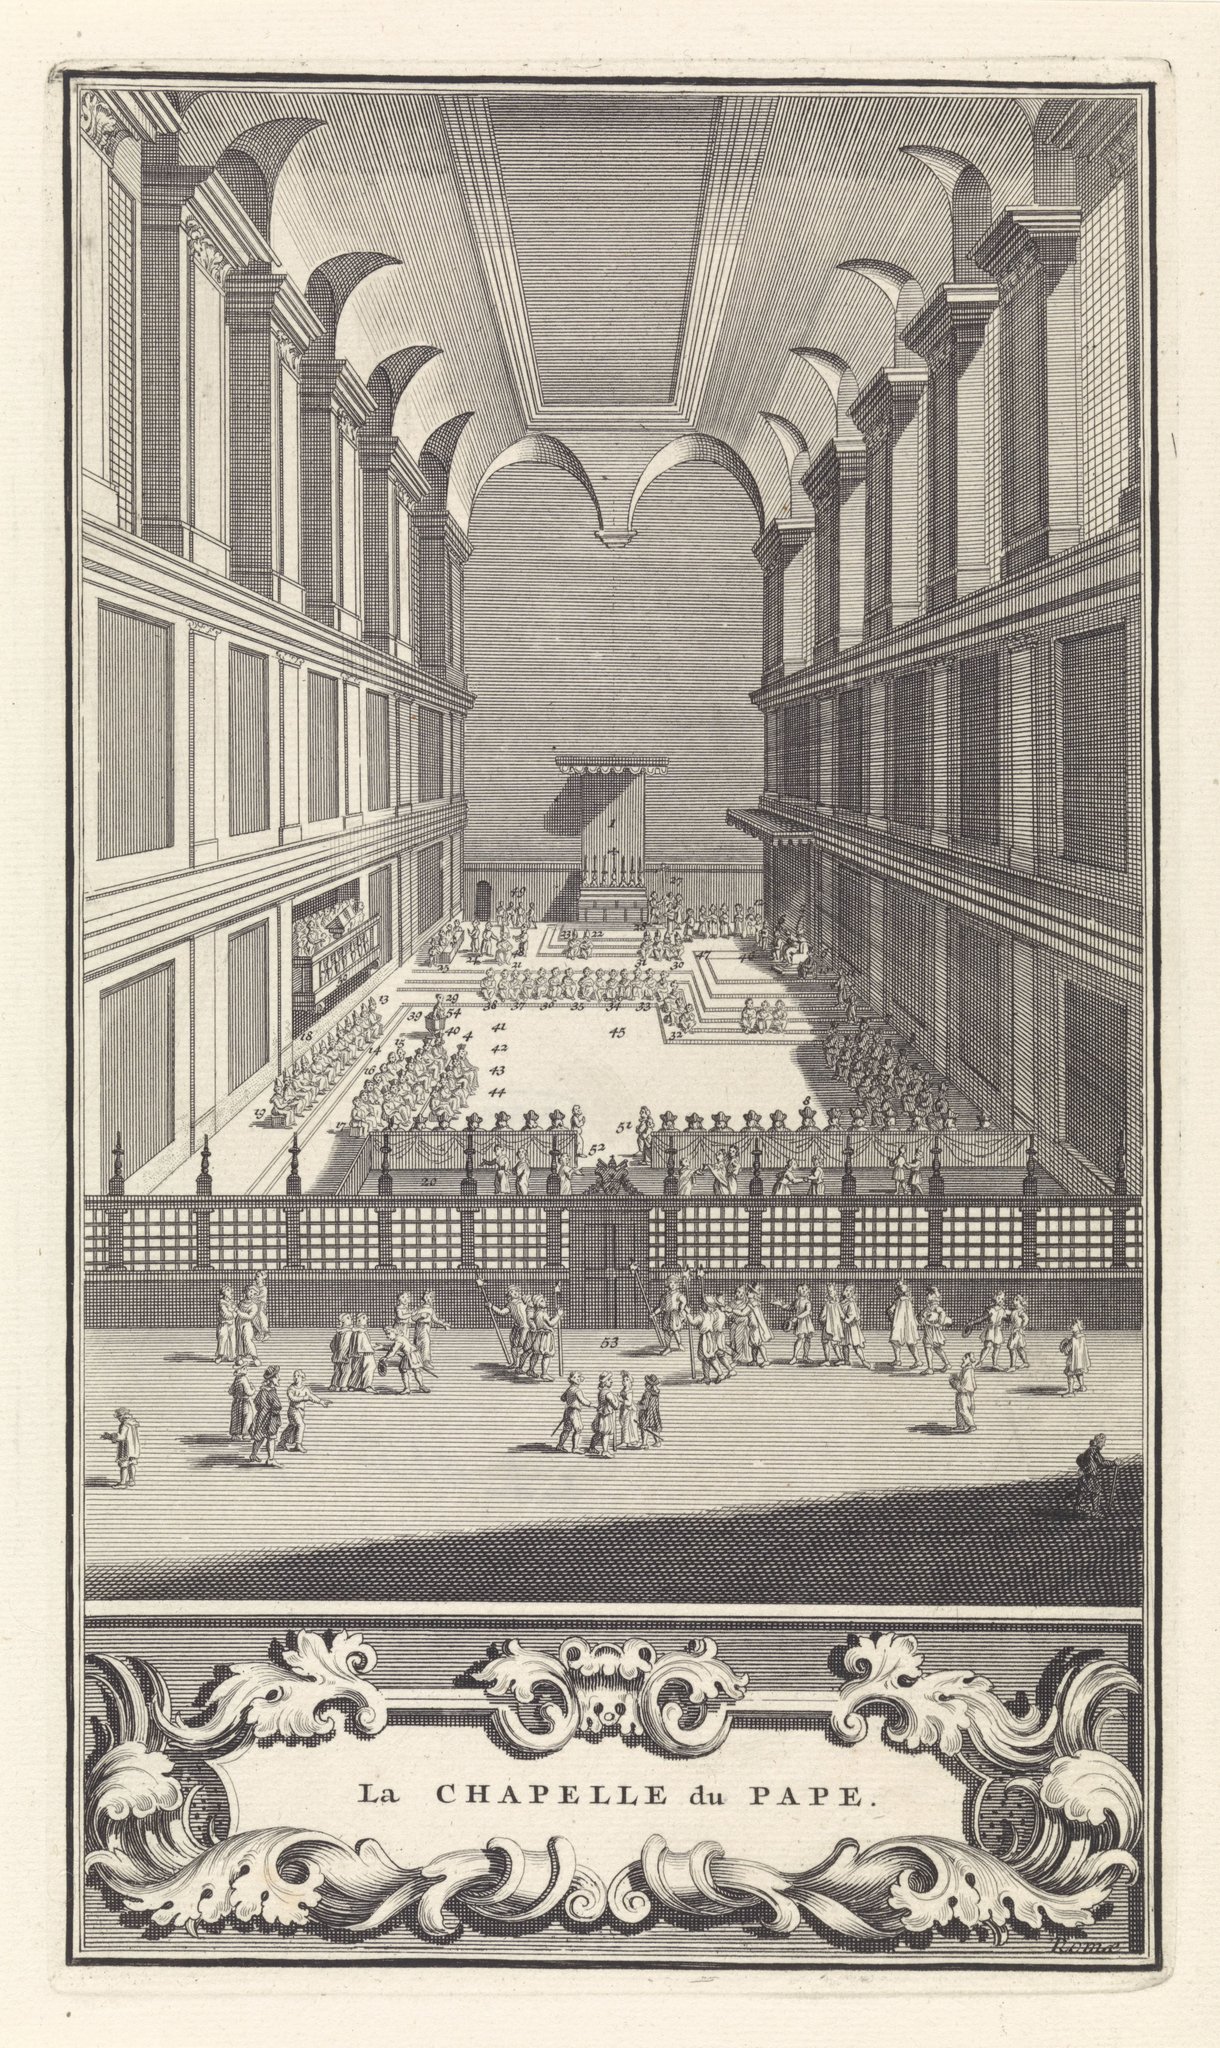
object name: book illustration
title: La Chapelle du Pape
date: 1723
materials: paper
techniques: engraving, etching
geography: rome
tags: interior of church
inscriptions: collector's mark: Lugt 2228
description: Prent gebruikt in of in andere edities van: Picart, Bernard. Ceremonies et coutumes religieuses de tous les peuples du monde (...). Tome premier, qui contient les ceremonies des juifs & des chrétiens catholiques. Deel 1. Amsterdam: Jean Frederic Bernard, 1723, na p. 70.